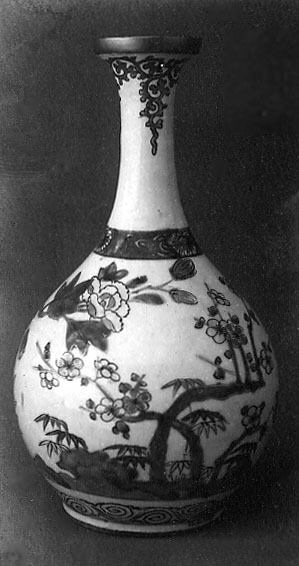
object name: bottle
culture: japanese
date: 1701-1800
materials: glaze, porcelain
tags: flowers